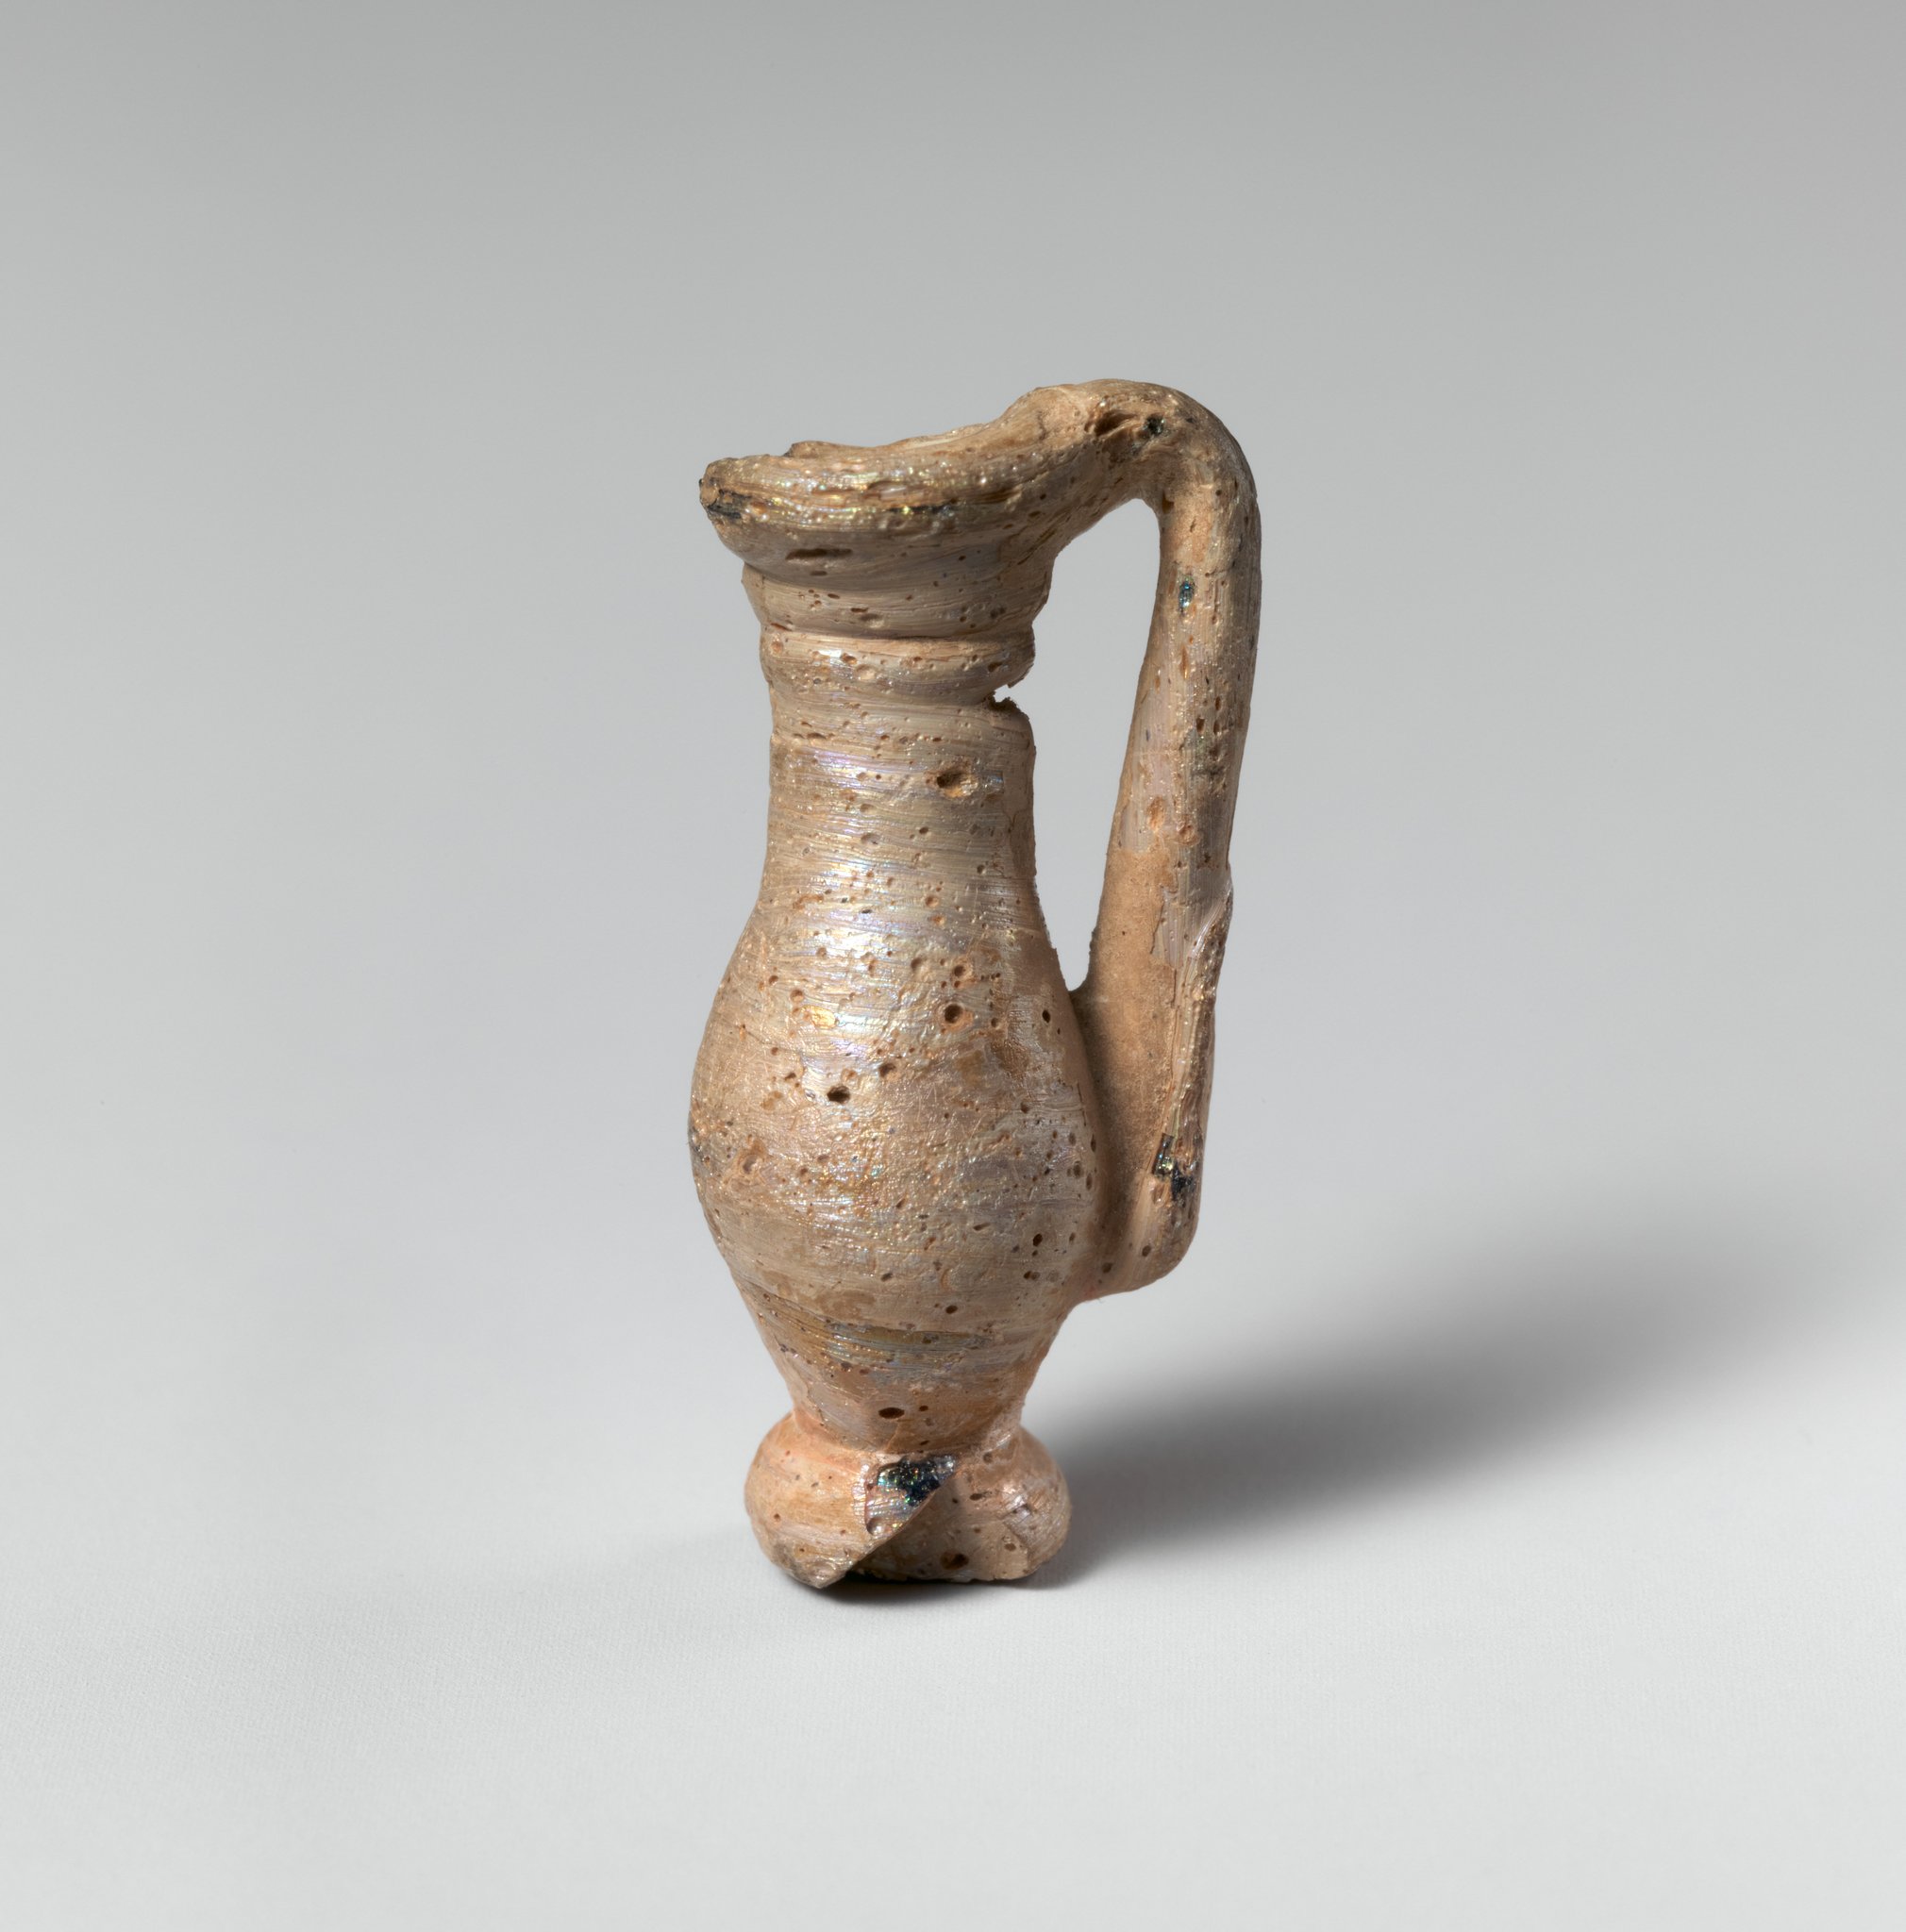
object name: pendant in the form of a jug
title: Glass pendant in the form of a miniature jug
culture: roman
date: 301-433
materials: glass